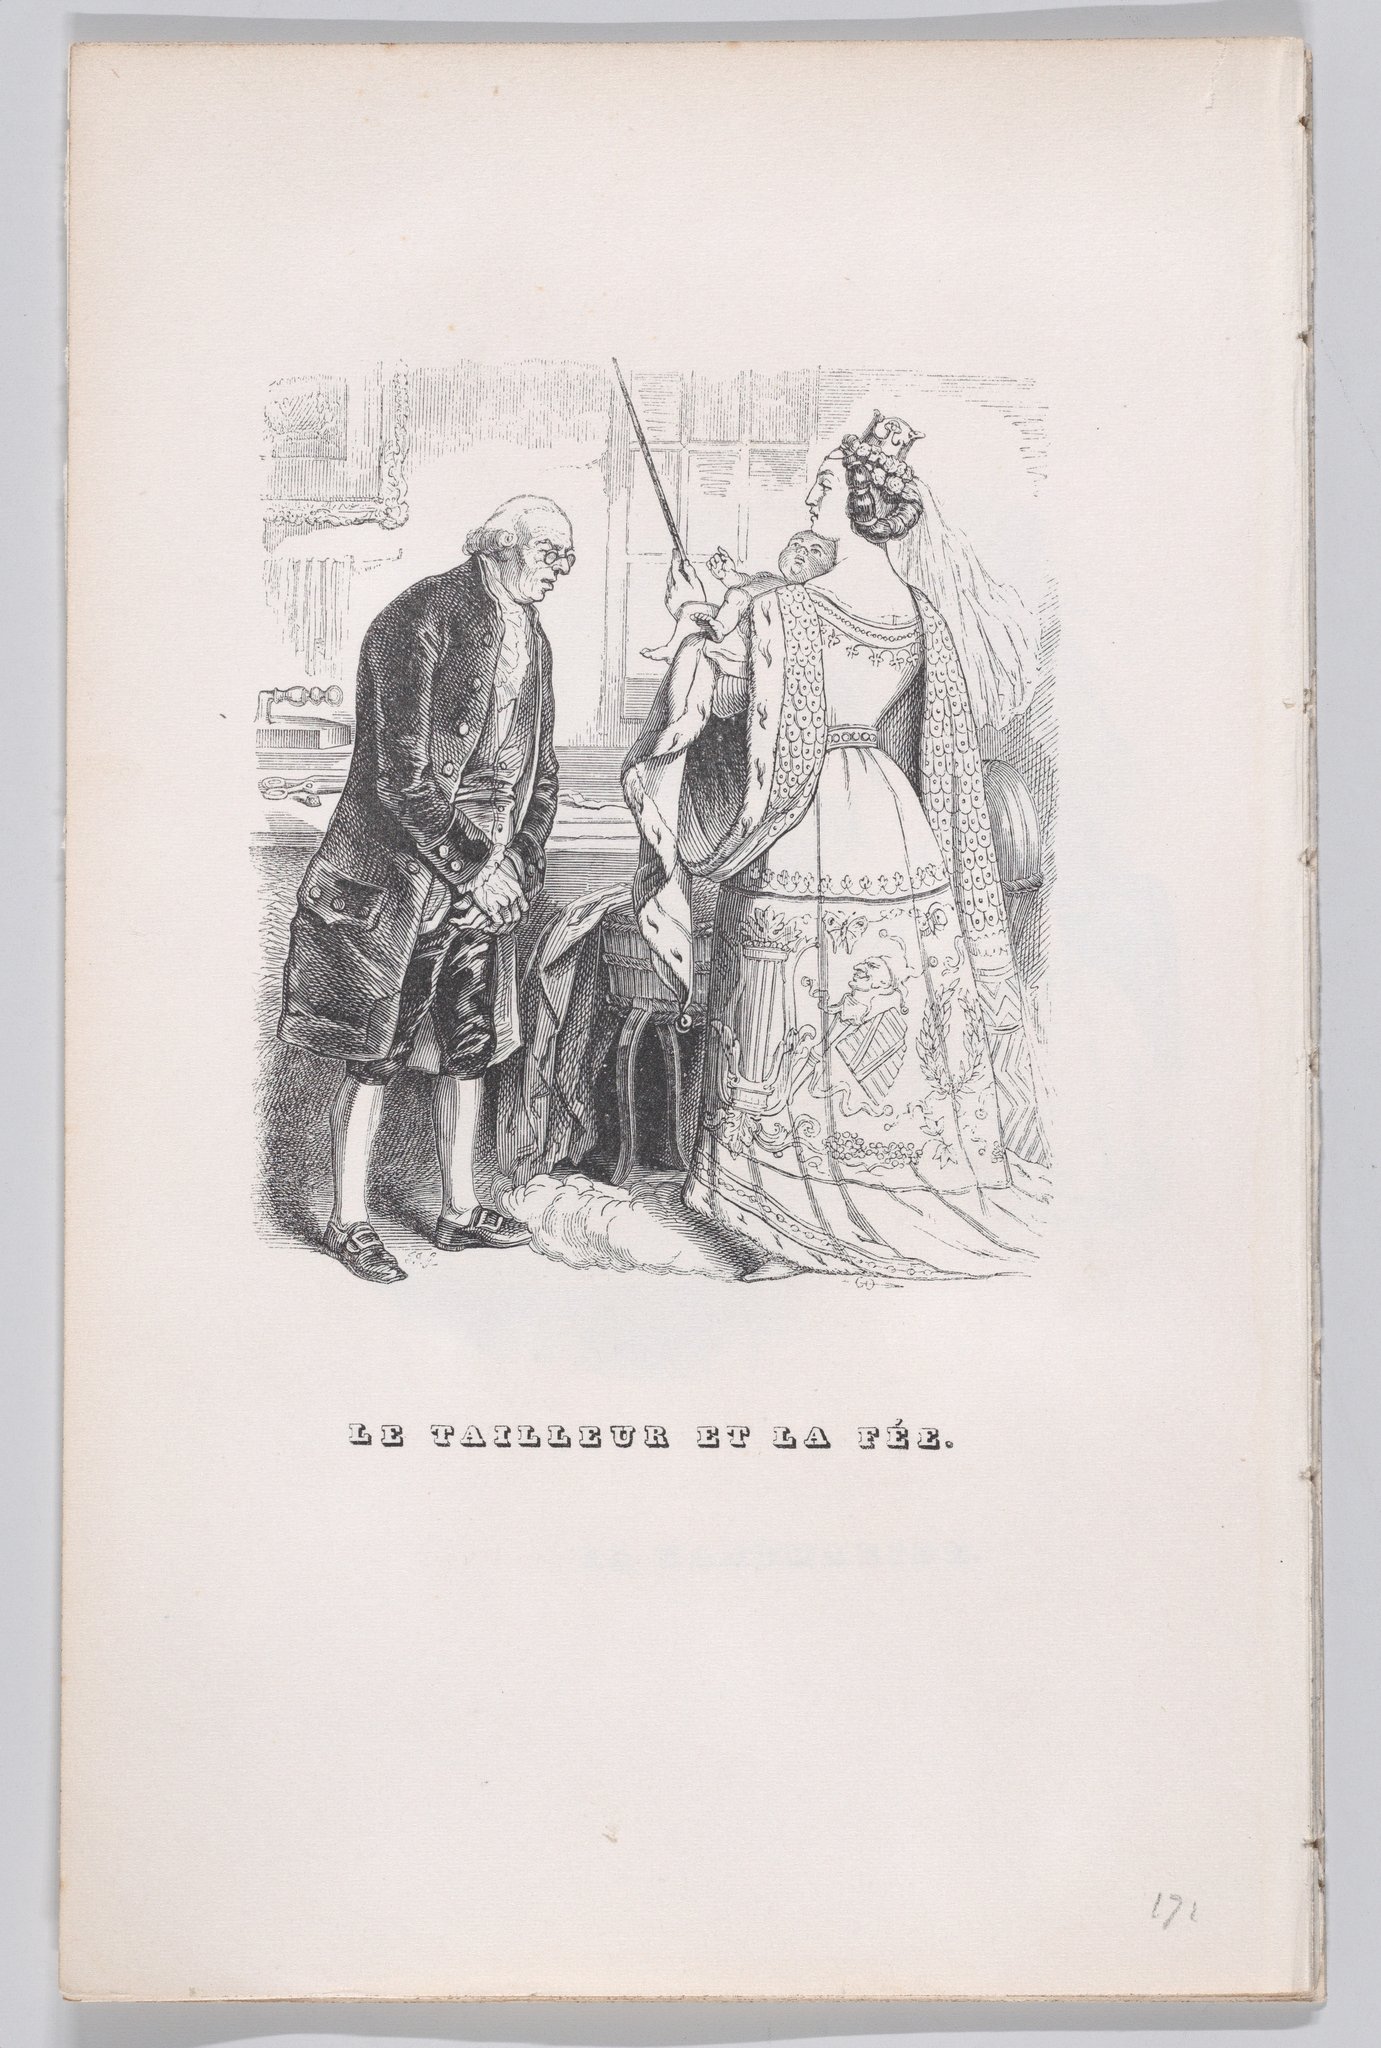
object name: print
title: The Tailor and the Fairy, from "The Complete Works of Béranger"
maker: j. j. grandville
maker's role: artist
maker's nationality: french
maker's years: 1803-1847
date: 1836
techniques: engraving